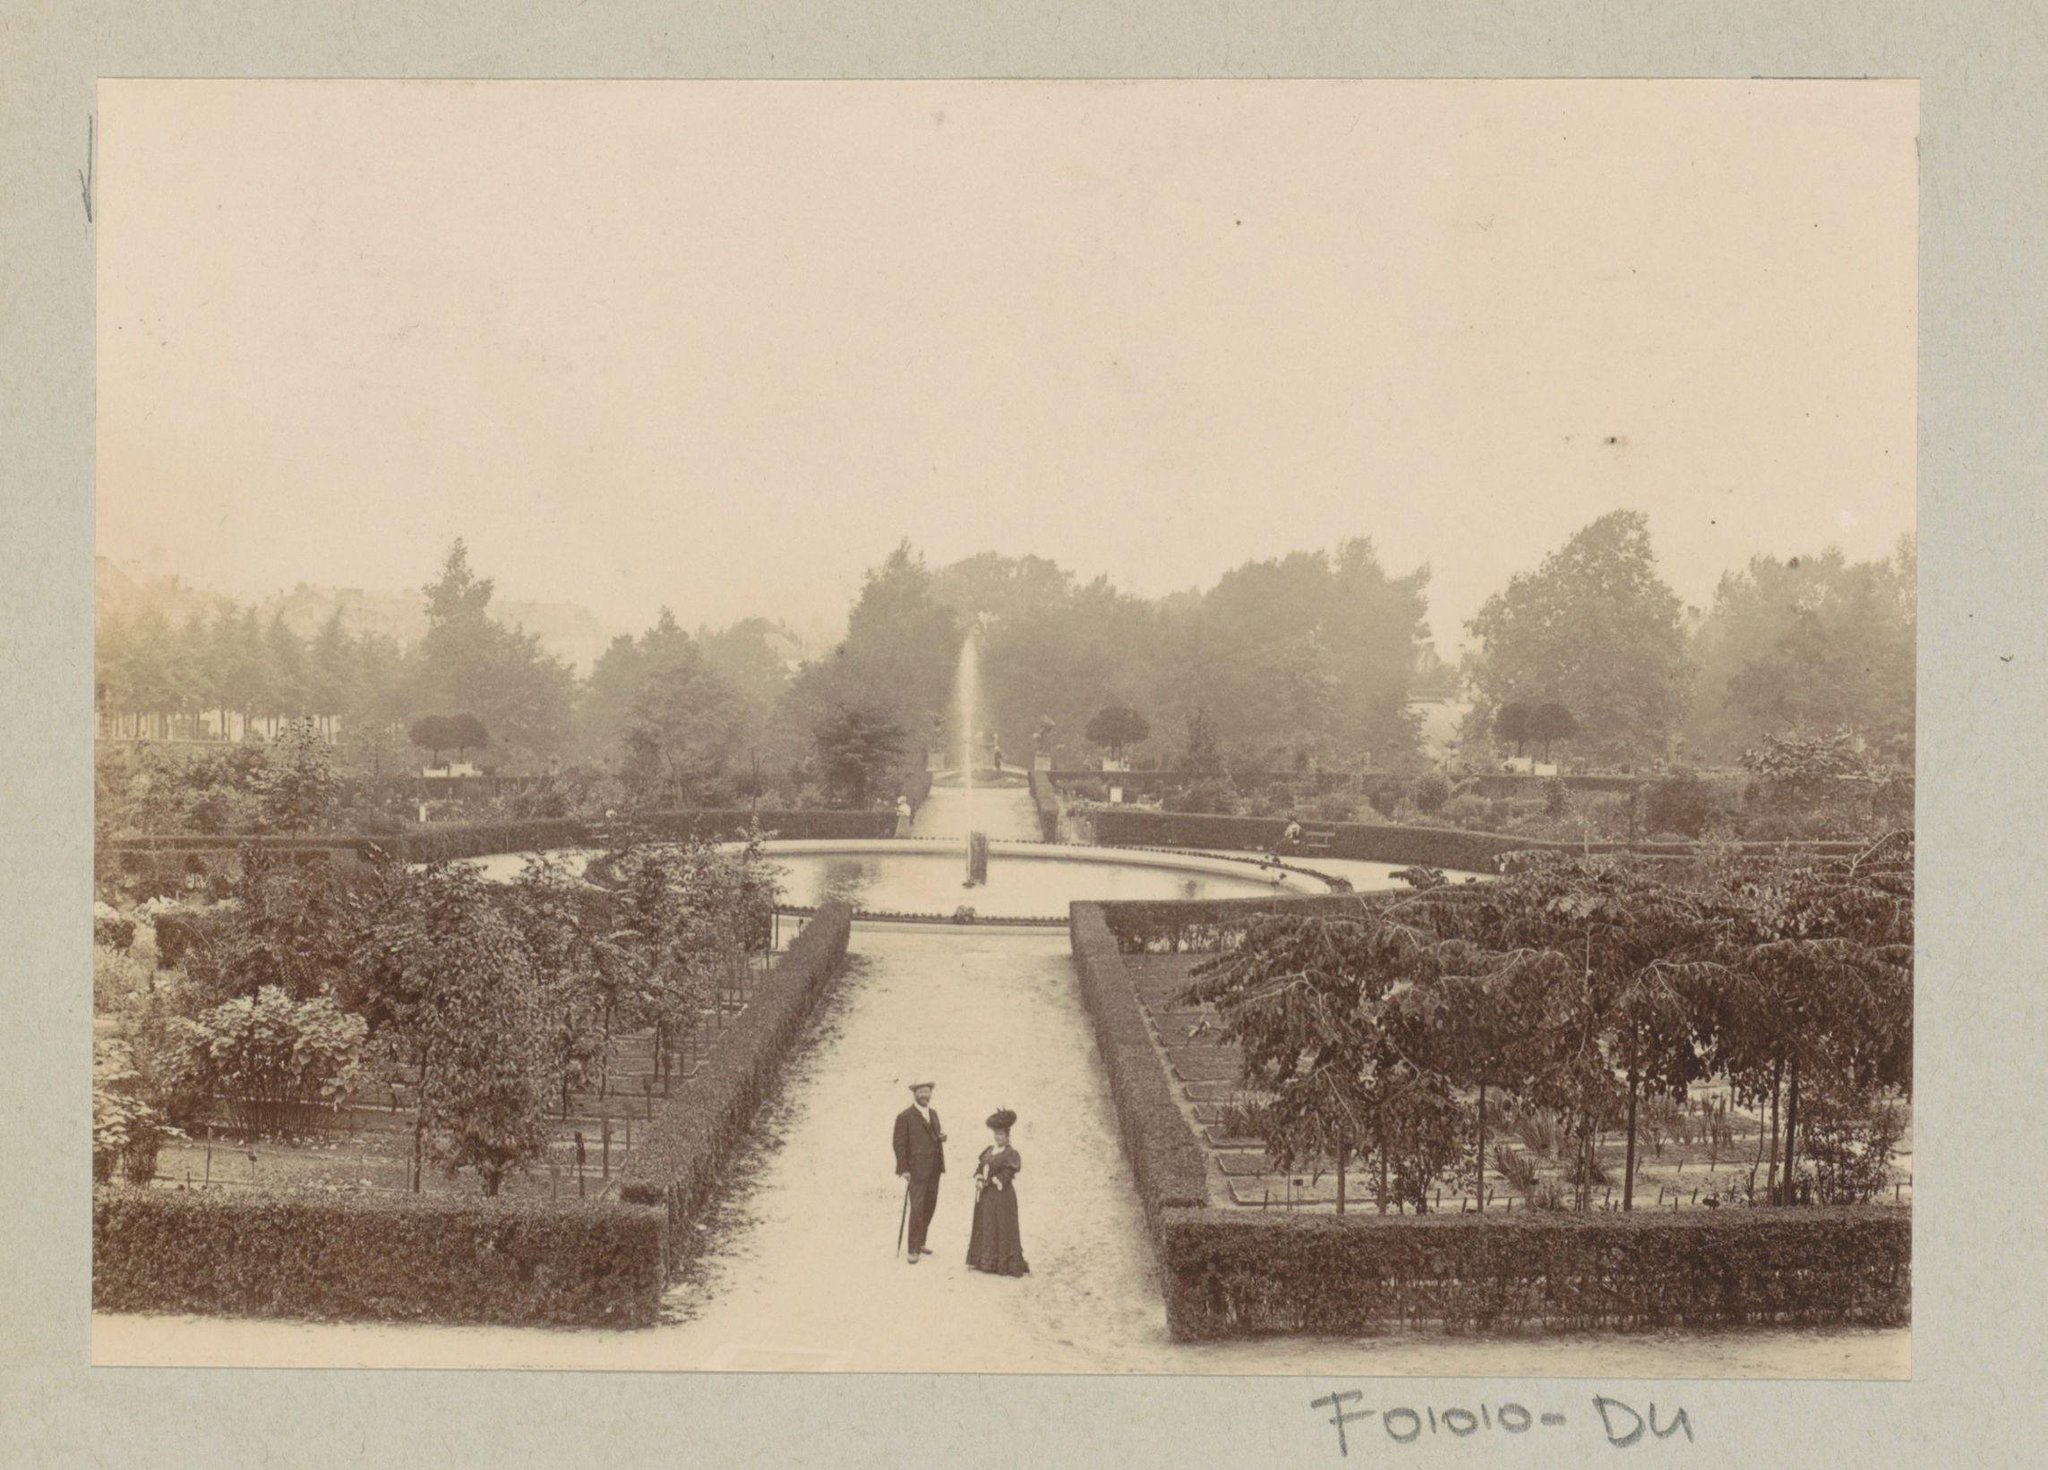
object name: photograph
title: Park met hagen en wandelaars, vermoedelijk in Brussel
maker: Anonymous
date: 1900-1910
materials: photographic support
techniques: daylight paper print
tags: public gardens, park (+ city(-scape) with figures, staffage), brussels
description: Onderdeel van Familiealbum met onder meer foto's van Wijnhandel Kraaij & Co. Bordeaux-Amsterdam.